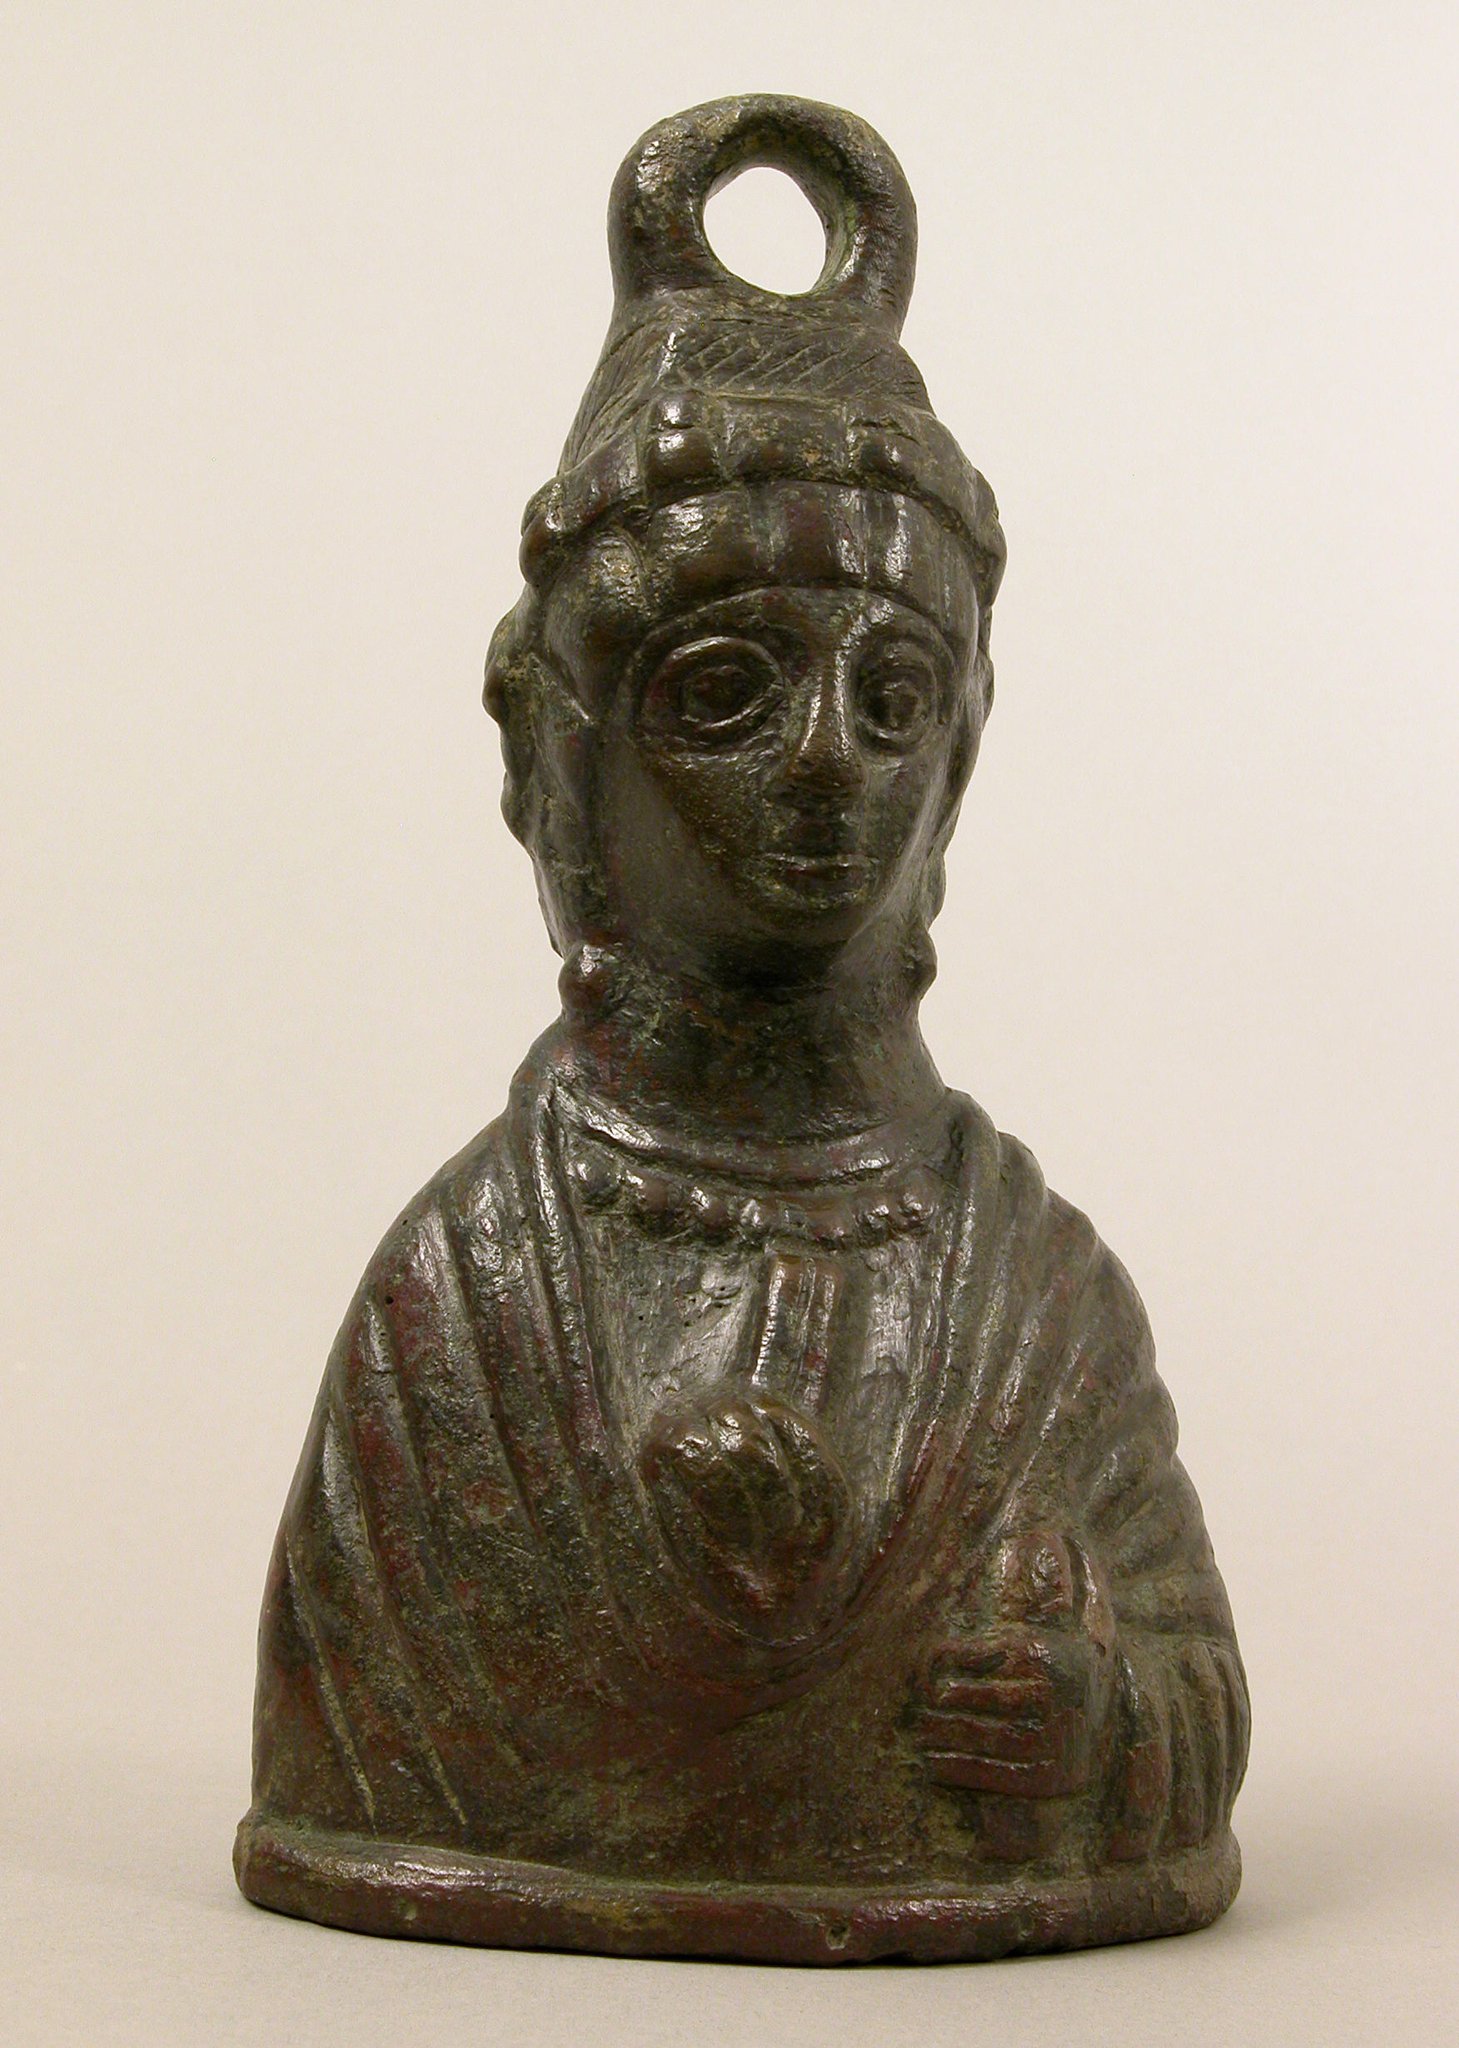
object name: steelyard weight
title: Weight in the Shape of a Byzantine Empress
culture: byzantine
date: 401-500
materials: copper alloy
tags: portraits,women